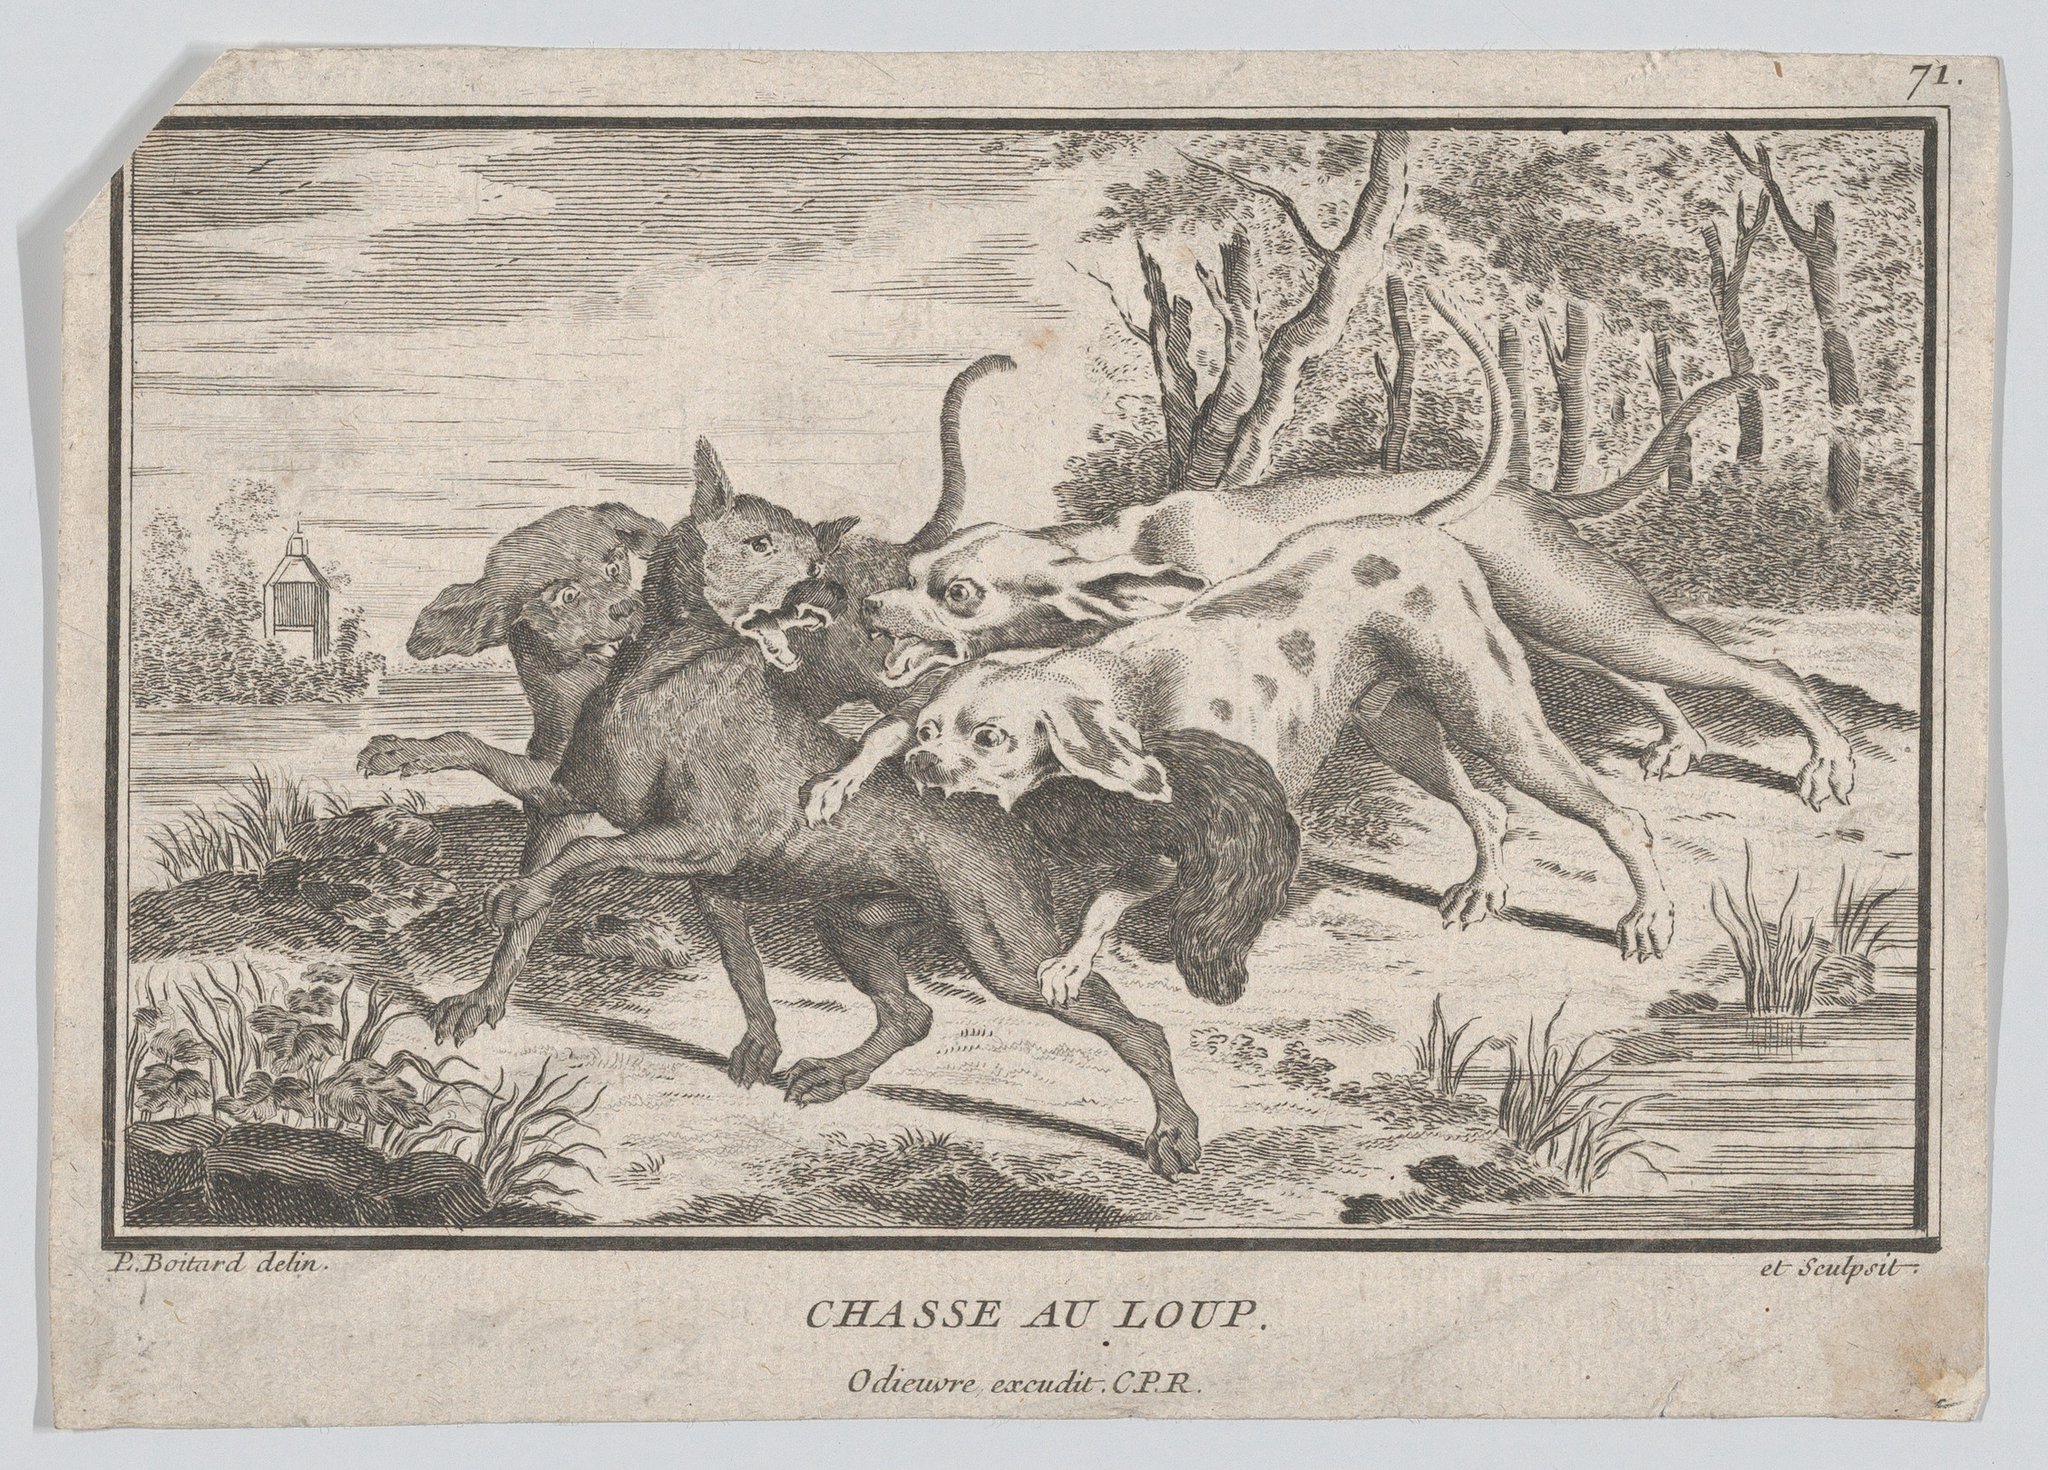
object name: print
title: Wolf Hunt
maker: louis pierre boitard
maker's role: artist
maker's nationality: british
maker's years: 1758-1858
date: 1747-1763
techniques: engraving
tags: animals,hunting